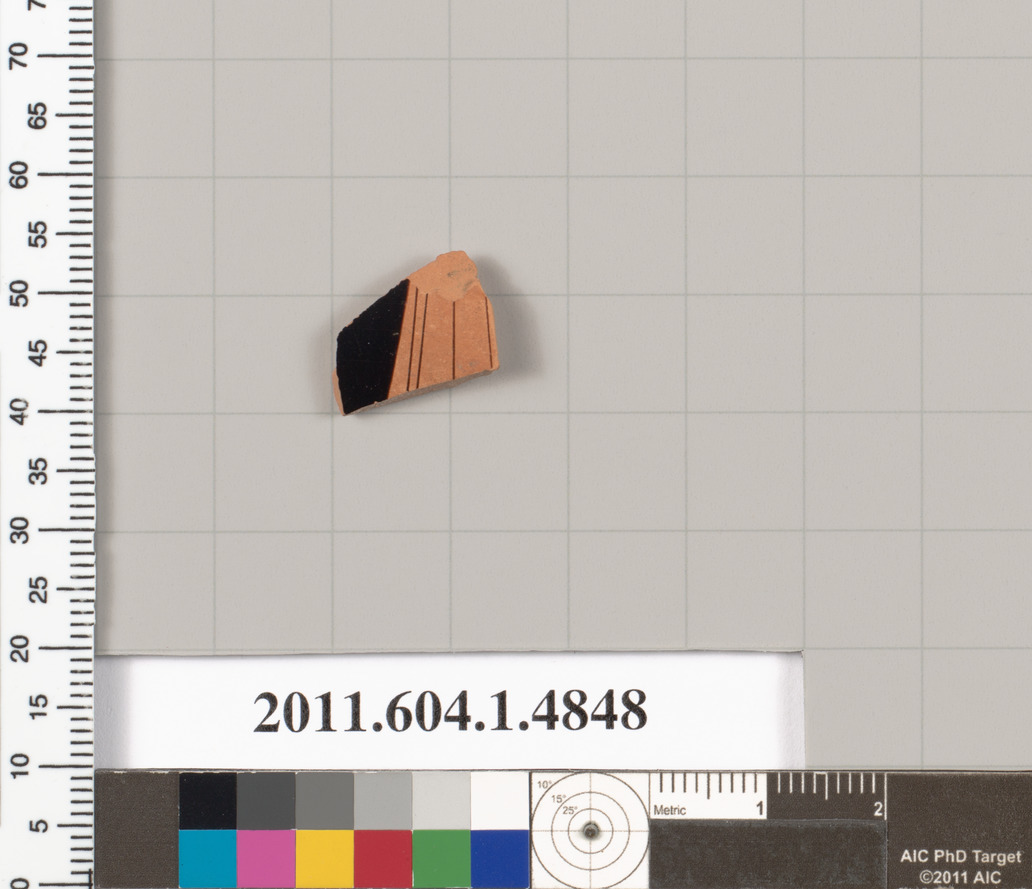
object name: kylix fragment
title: Terracotta fragment of a kylix (drinking cup)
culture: greek, attic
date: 475-451 BCE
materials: terracotta